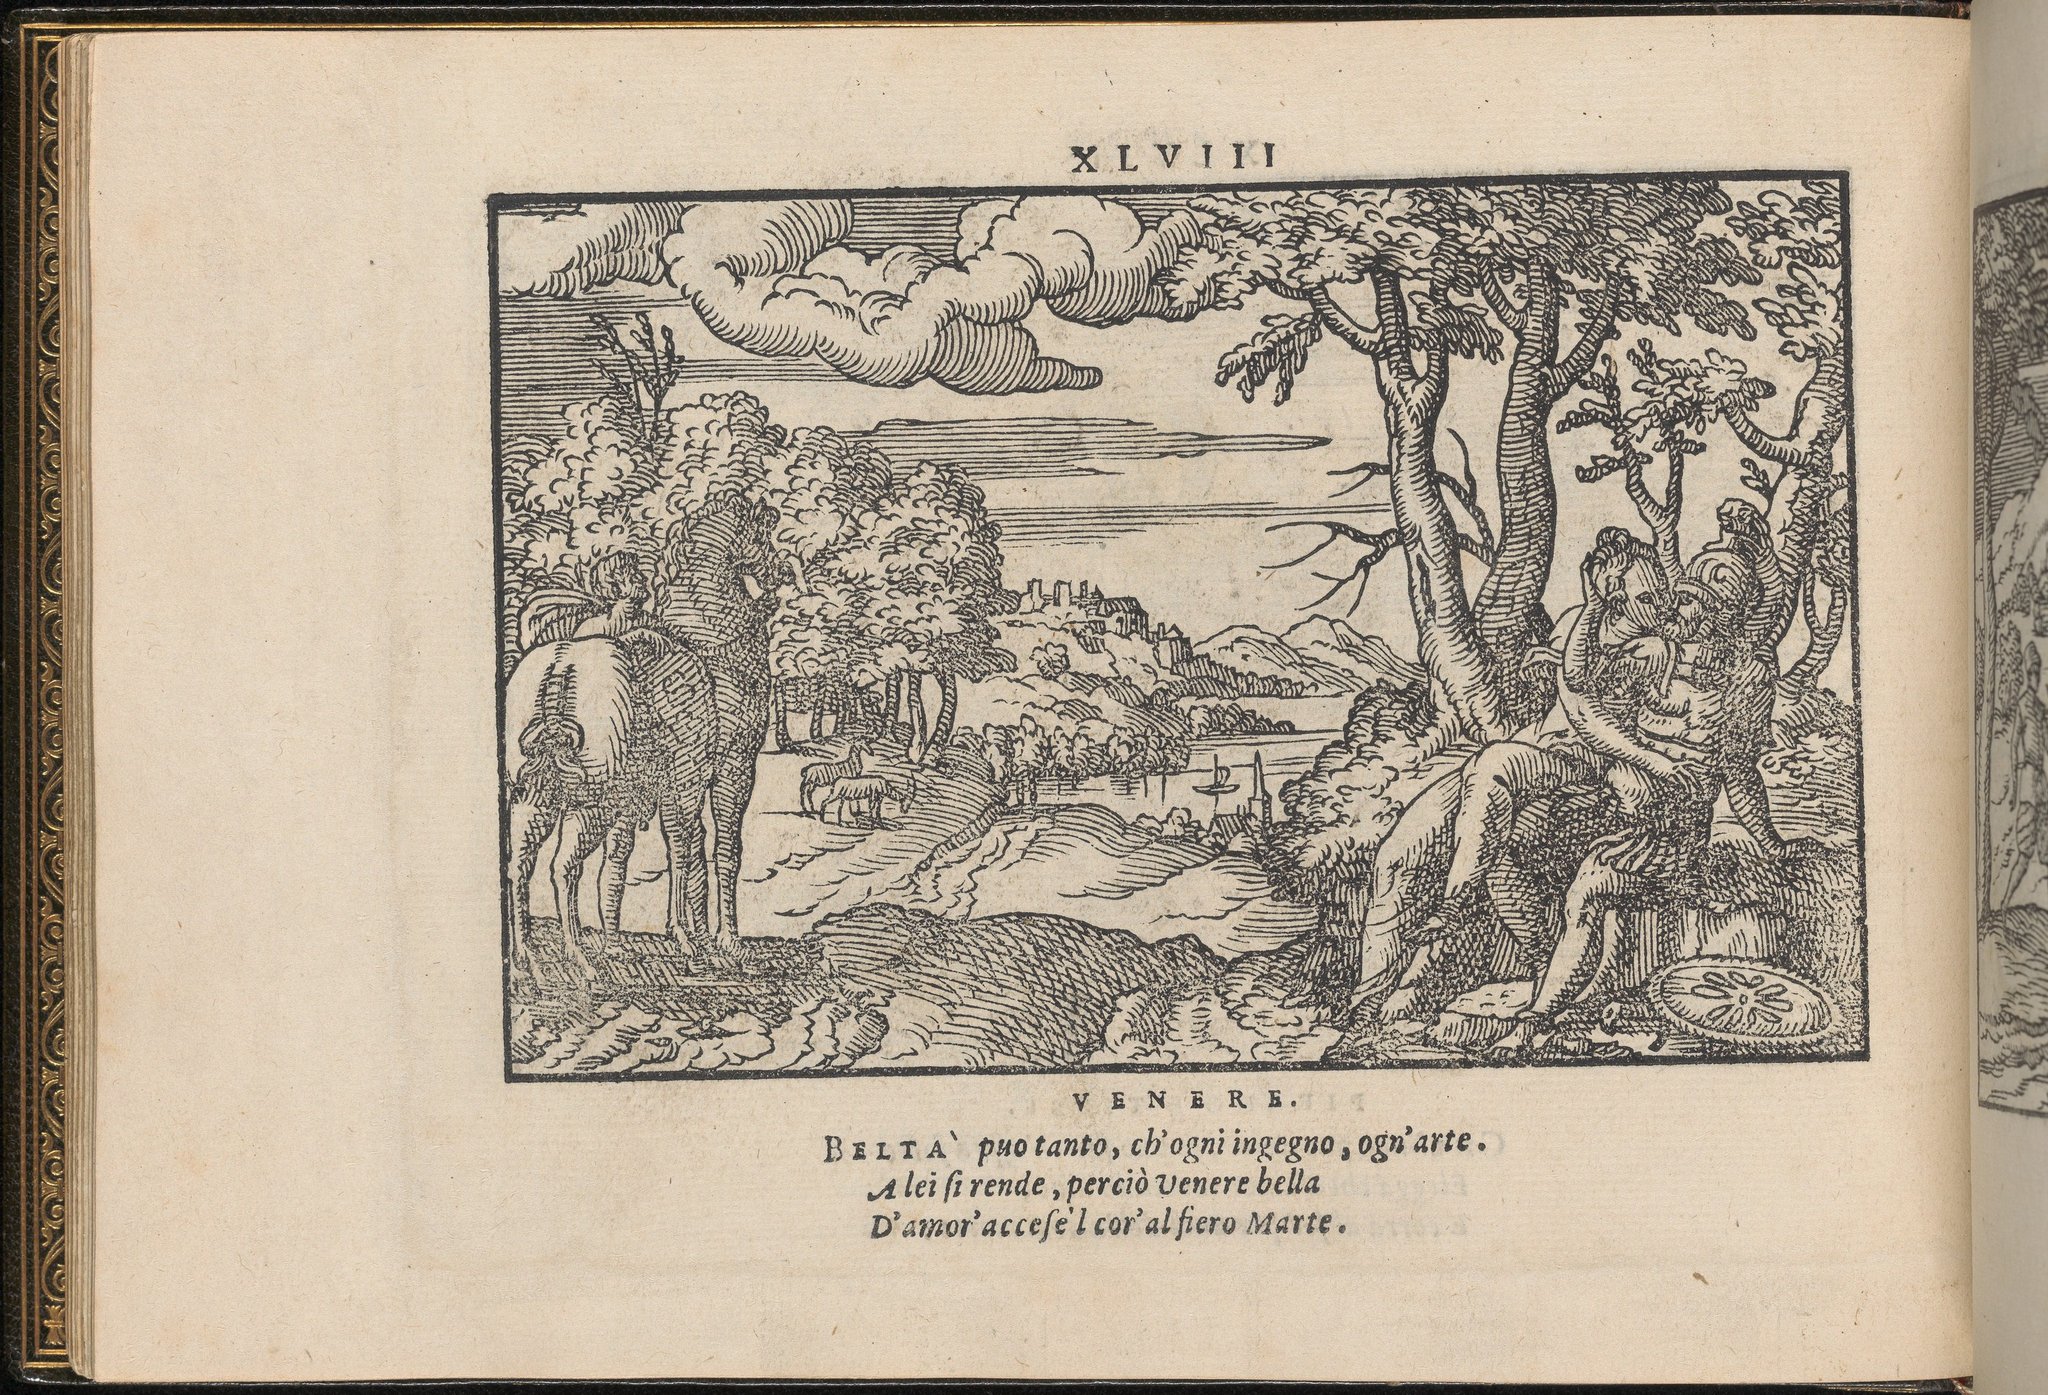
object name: book print ornament architecture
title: La Vera Perfettione del Disegno di varie sorti di recami, page 24 (verso)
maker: giovanni ostaus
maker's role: publisher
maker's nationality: italian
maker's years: 1507-1607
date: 1567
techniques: woodcut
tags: mars,venus,horses,landscapes